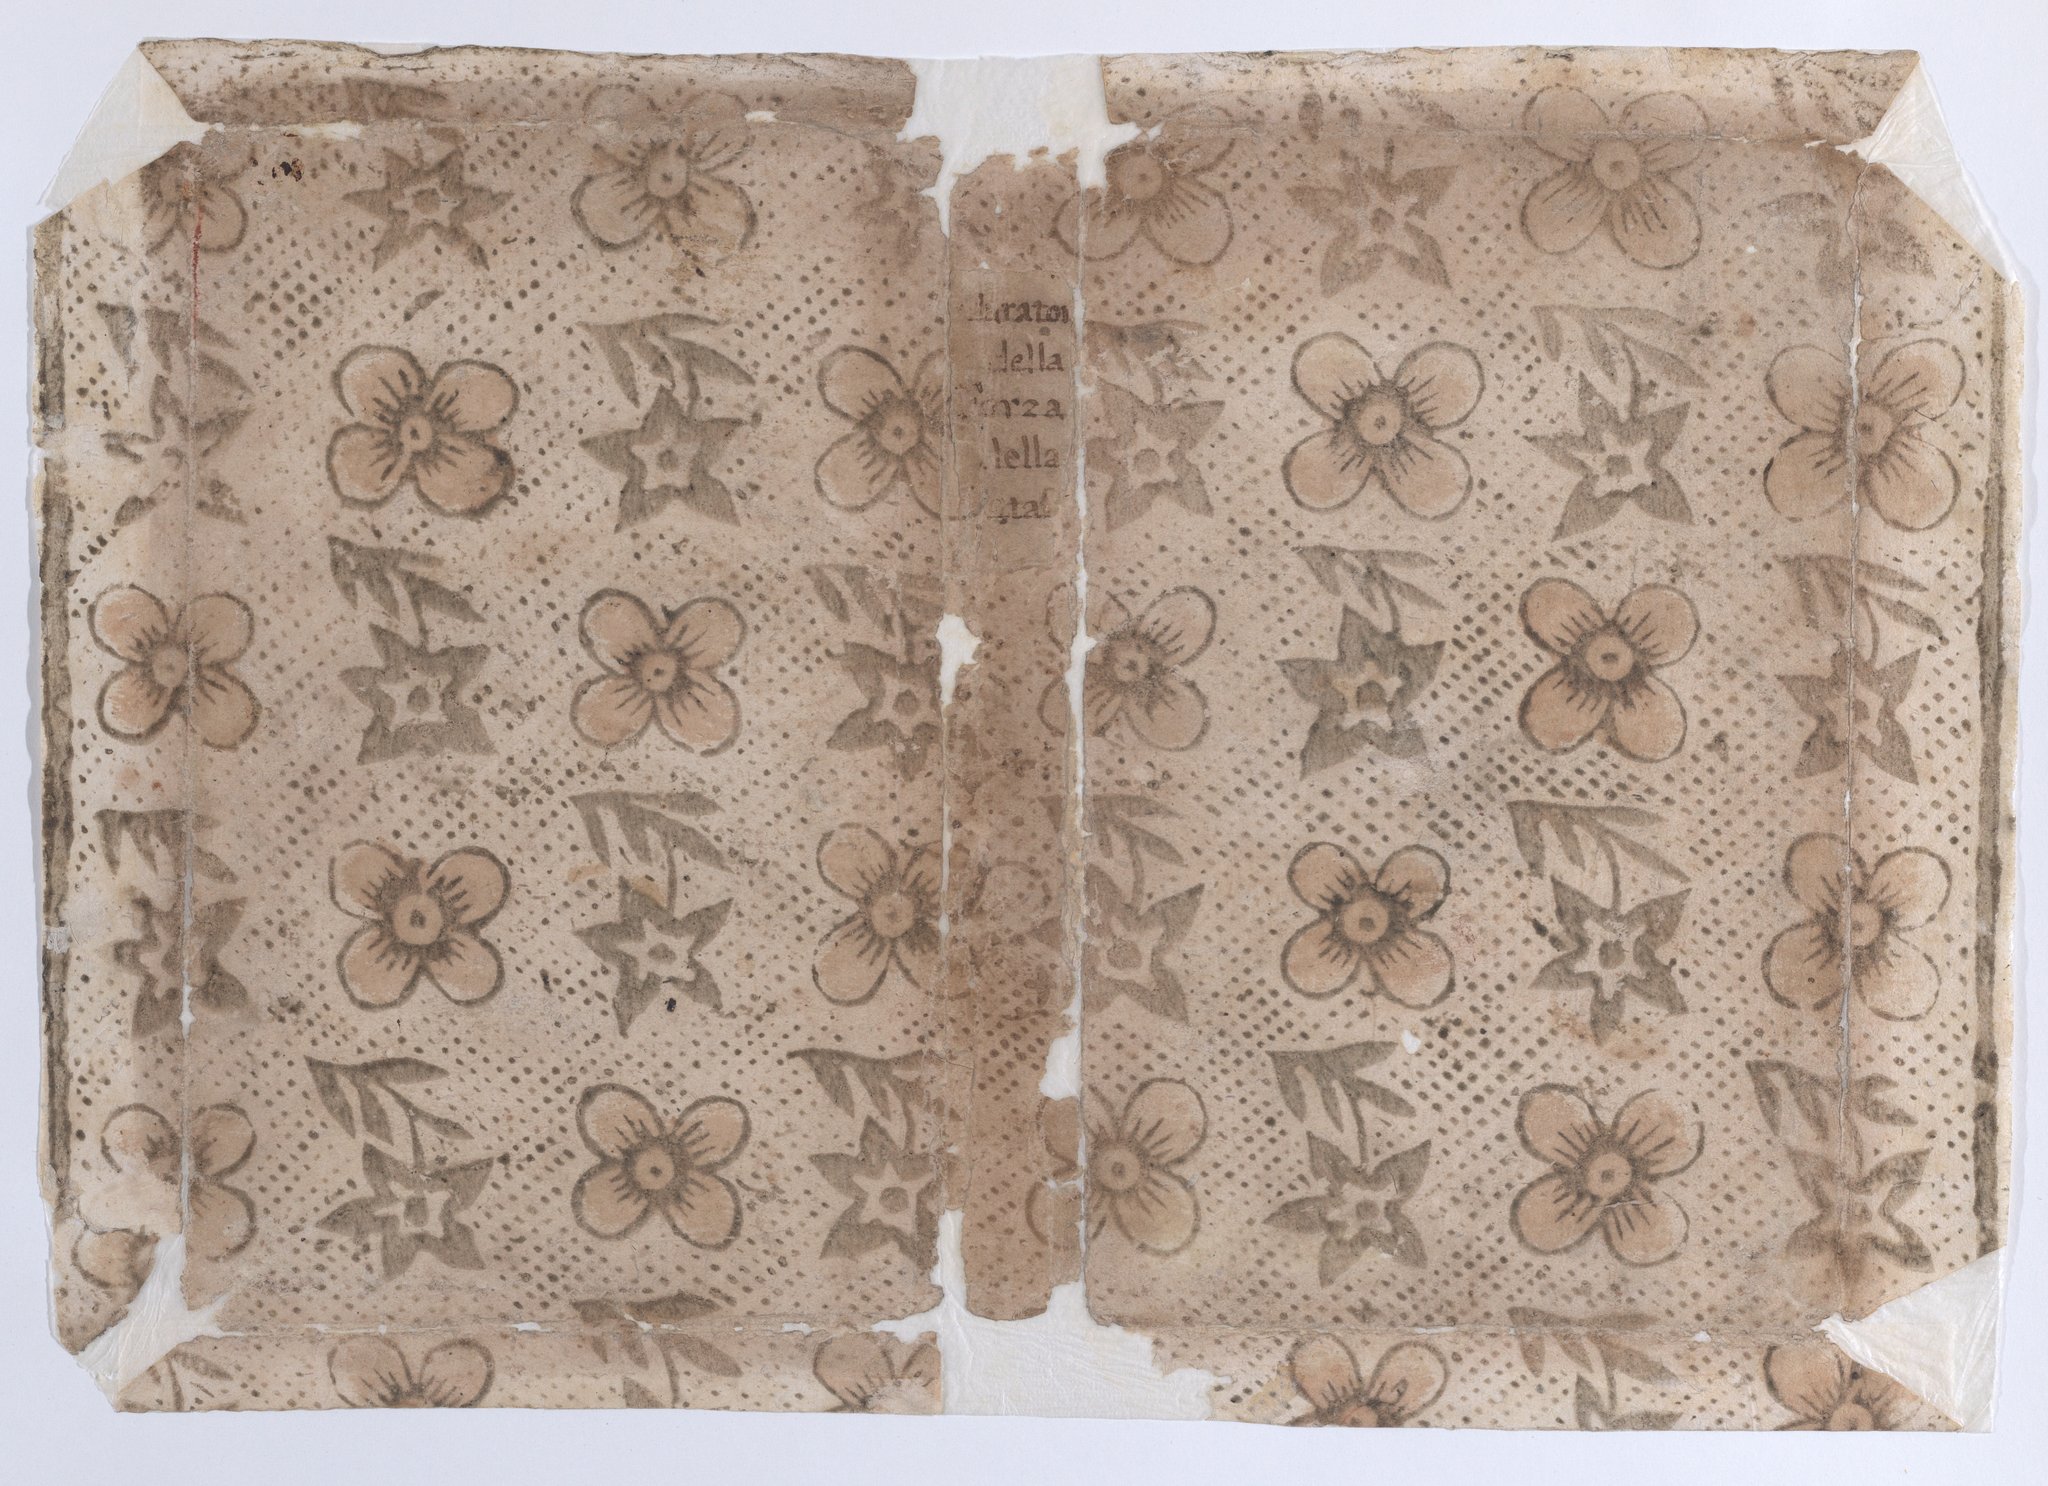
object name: print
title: Book cover with floral and dot pattern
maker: Anonymous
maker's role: artist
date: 1801-1900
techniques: relief print